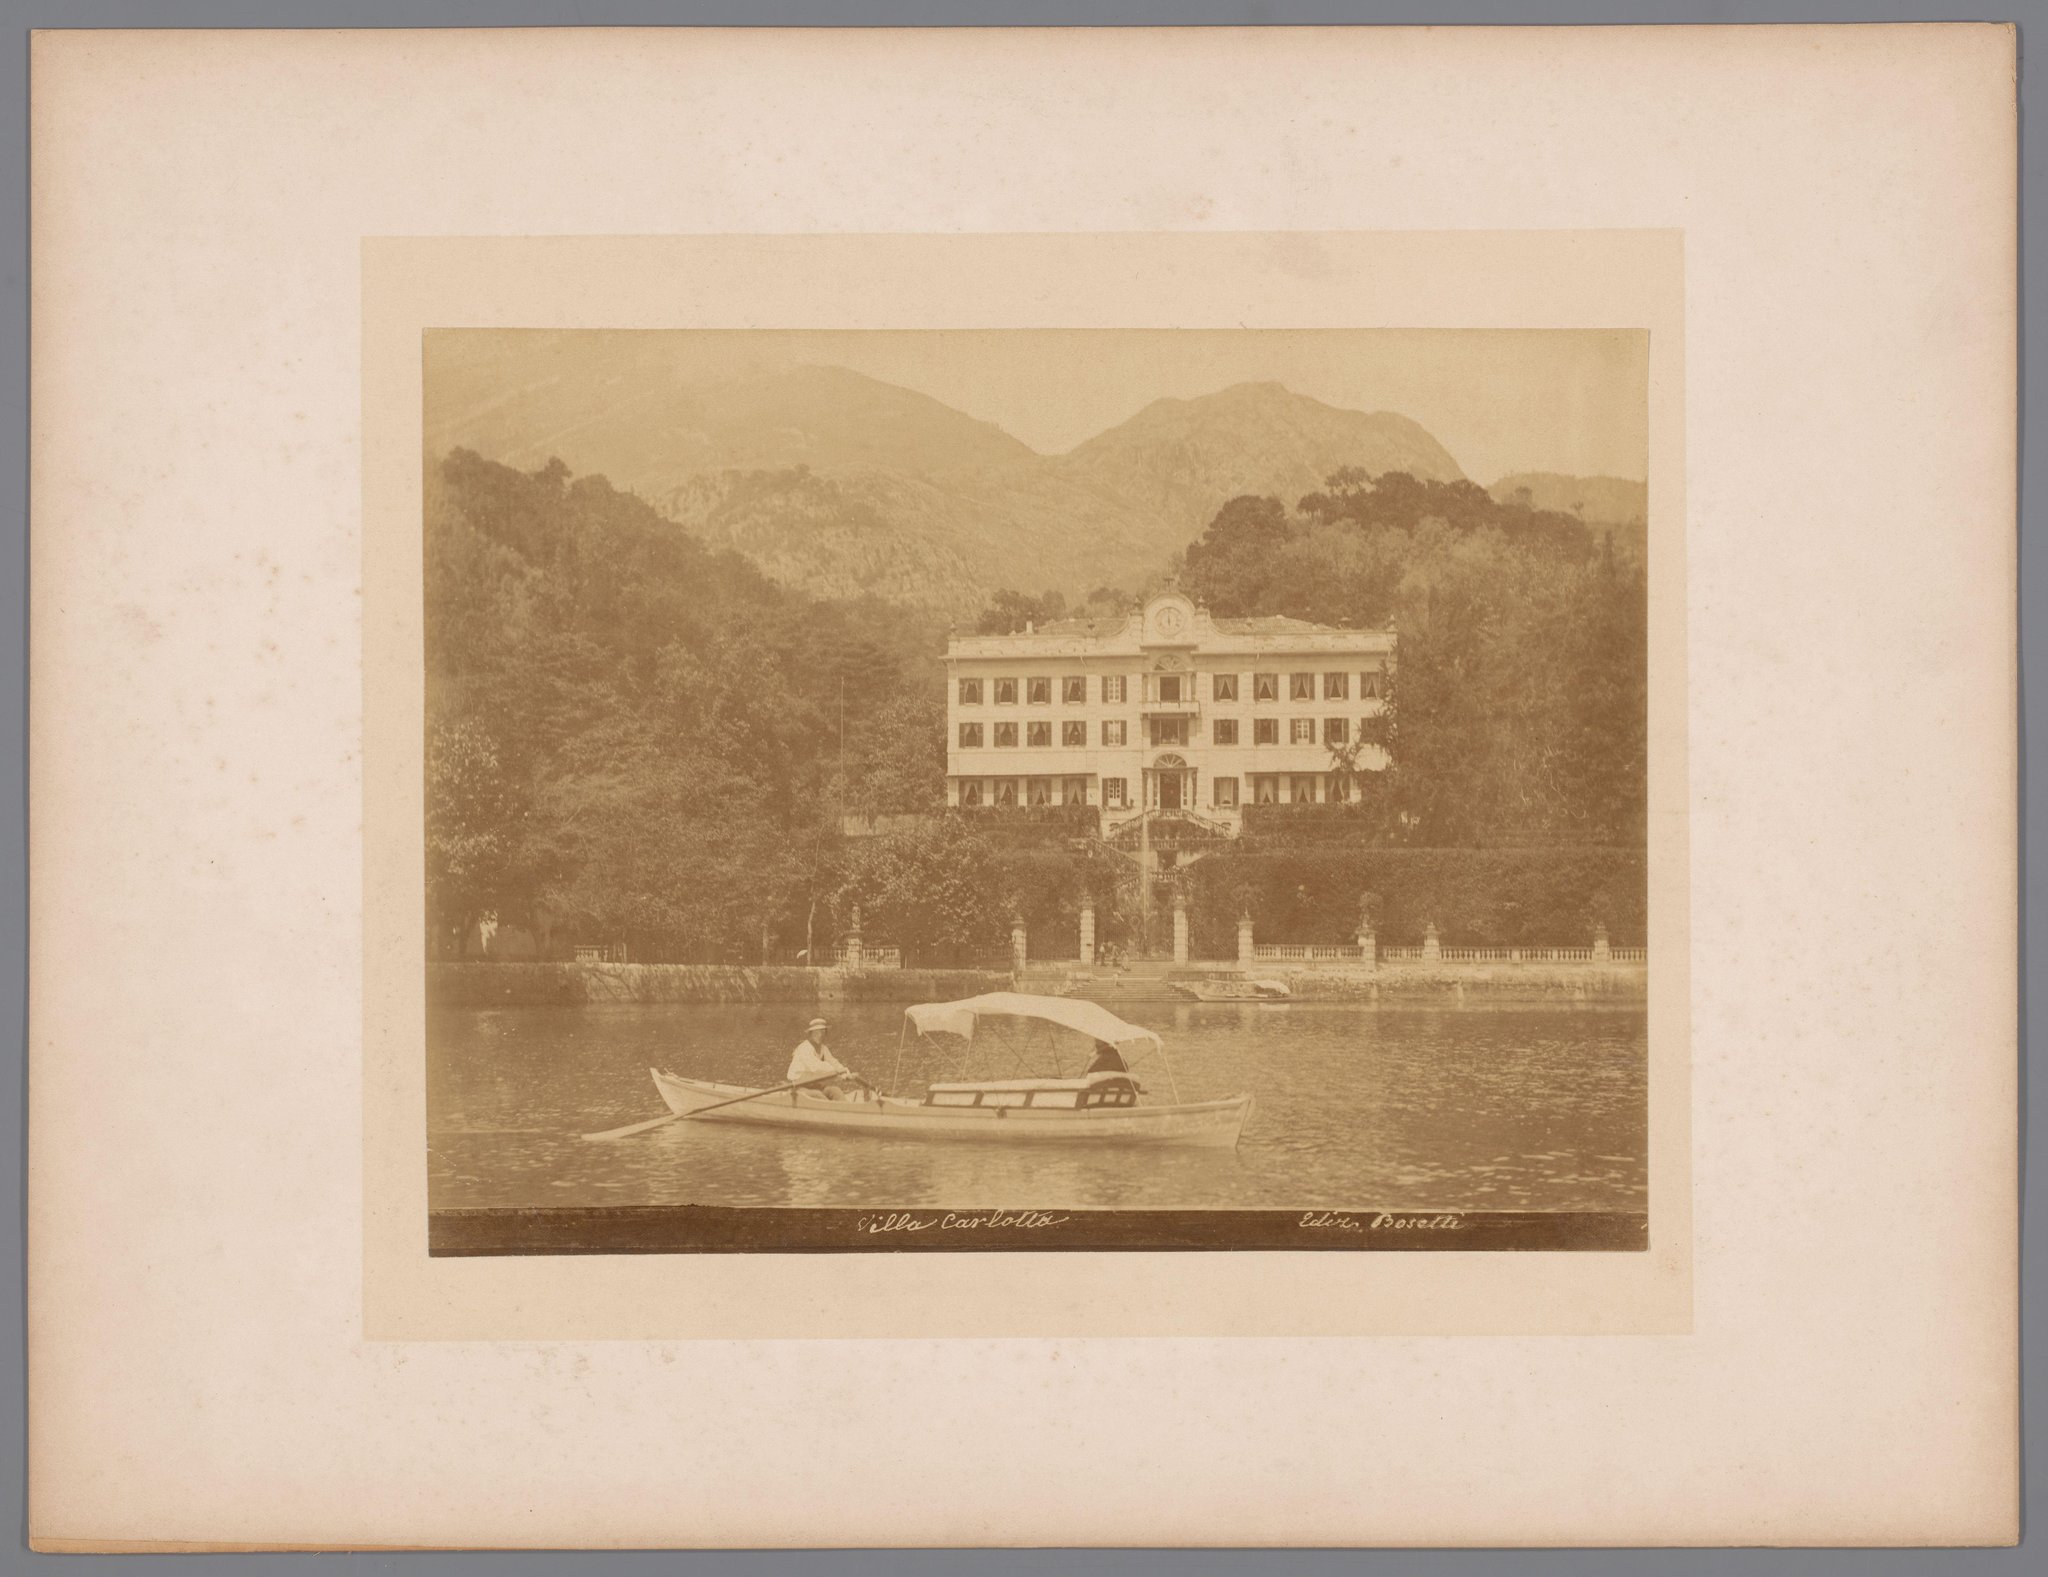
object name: photograph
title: Villa Carlotta aan het Comomeer, Tremezzo, Italië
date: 1851-1900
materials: cardboard, paper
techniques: albumen print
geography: tremezzo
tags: lake, rowing facing backward, pulling, villa